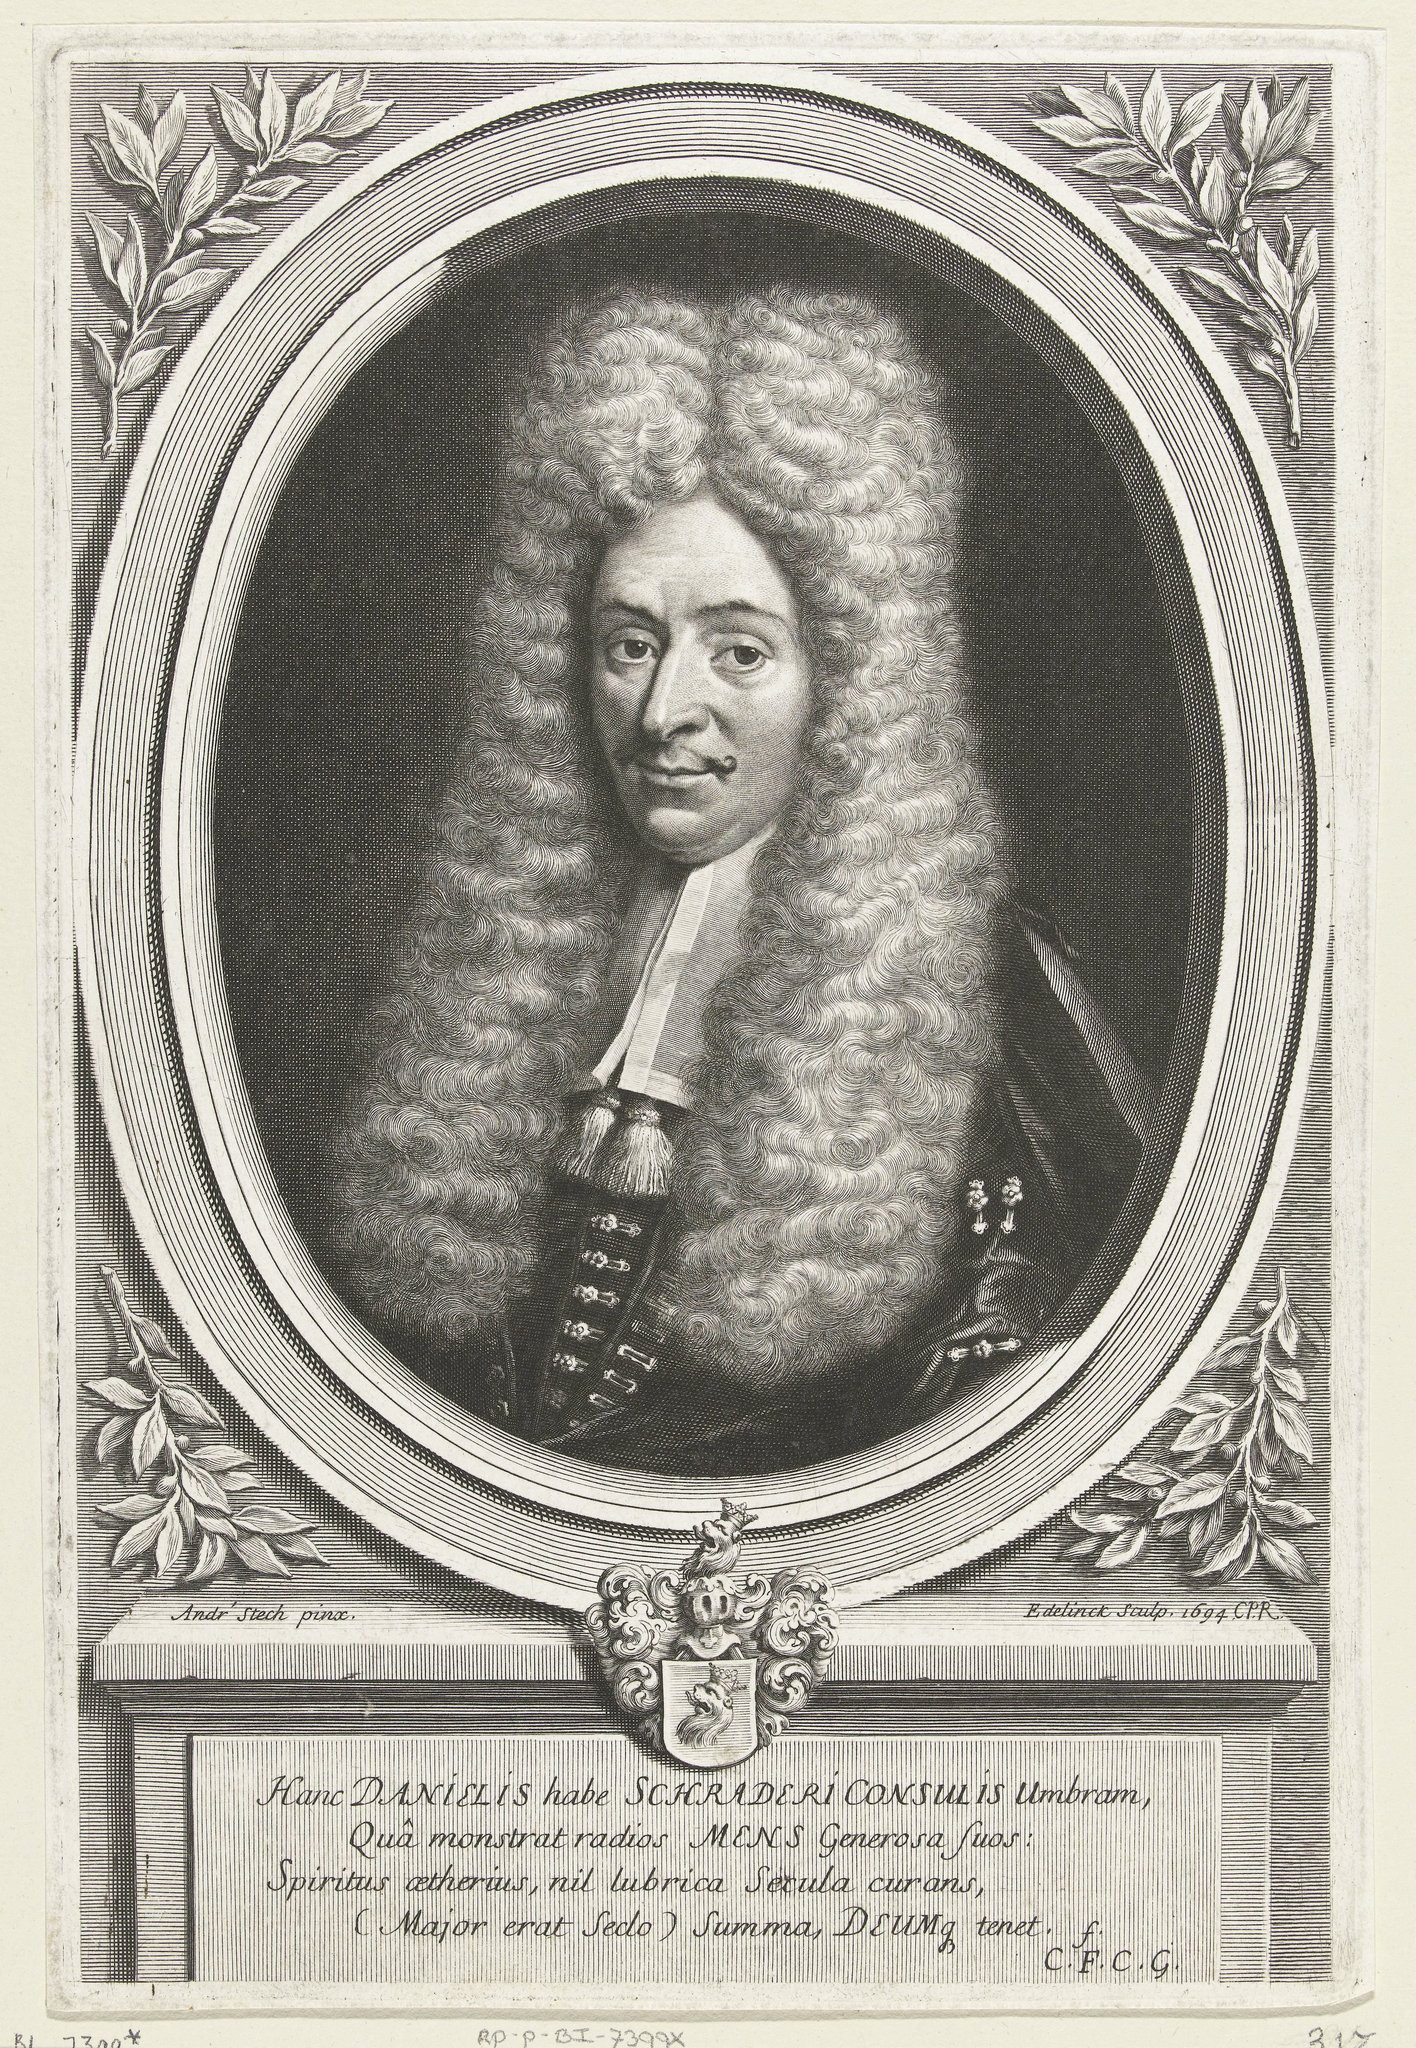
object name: print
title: Portret van Daniel Schrader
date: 1694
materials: paper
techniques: engraving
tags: daniel schrader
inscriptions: collector's mark: Lugt 240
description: Portret van Daniel Schrader met lange pruik afgebeeld in ovale omlijsting. In de vier hoeken rondom de lijst olijftakken en onder de lijst een console met vier regels tekst in Latijn en een wapen.